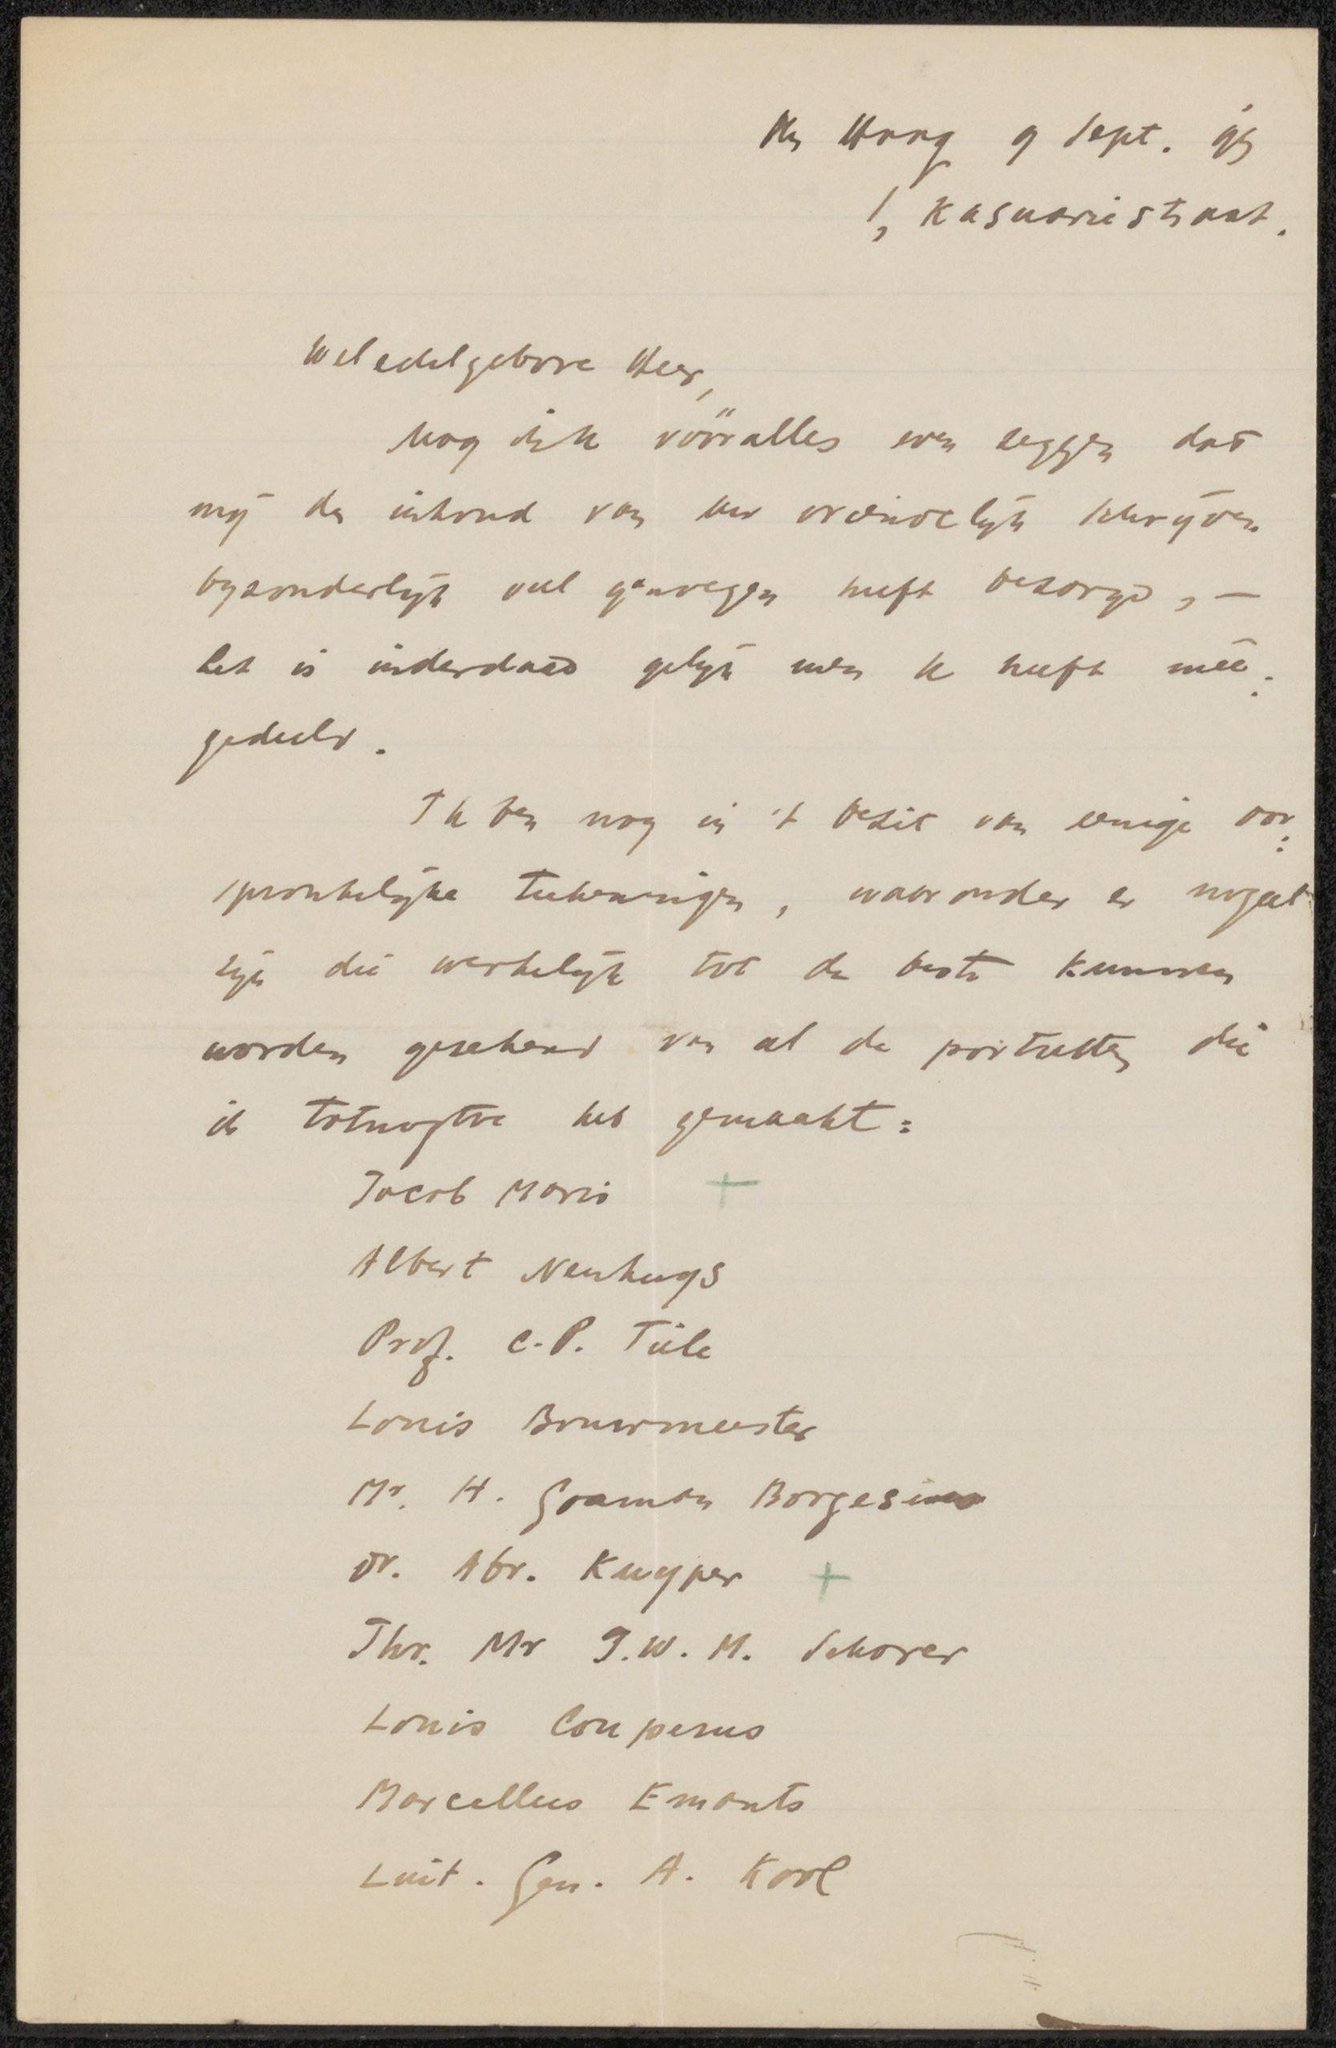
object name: letter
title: Brief aan Pieter Haverkorn van Rijsewijk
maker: hendrik johannes haverman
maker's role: draughtsman, print maker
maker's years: 1857-1928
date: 1899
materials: ink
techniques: pen, writing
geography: the hague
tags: the hague, painter, print maker, jacob maris, utrecht, albert neuhuys (1844-1914), draughtsman, pierre joseph hubert cuypers, abraham kuyper, pieter haverkorn van rijsewijk, louis couperus, voorburg, marcellus emants, drawing, historical persons (portraits and scenes from the life)